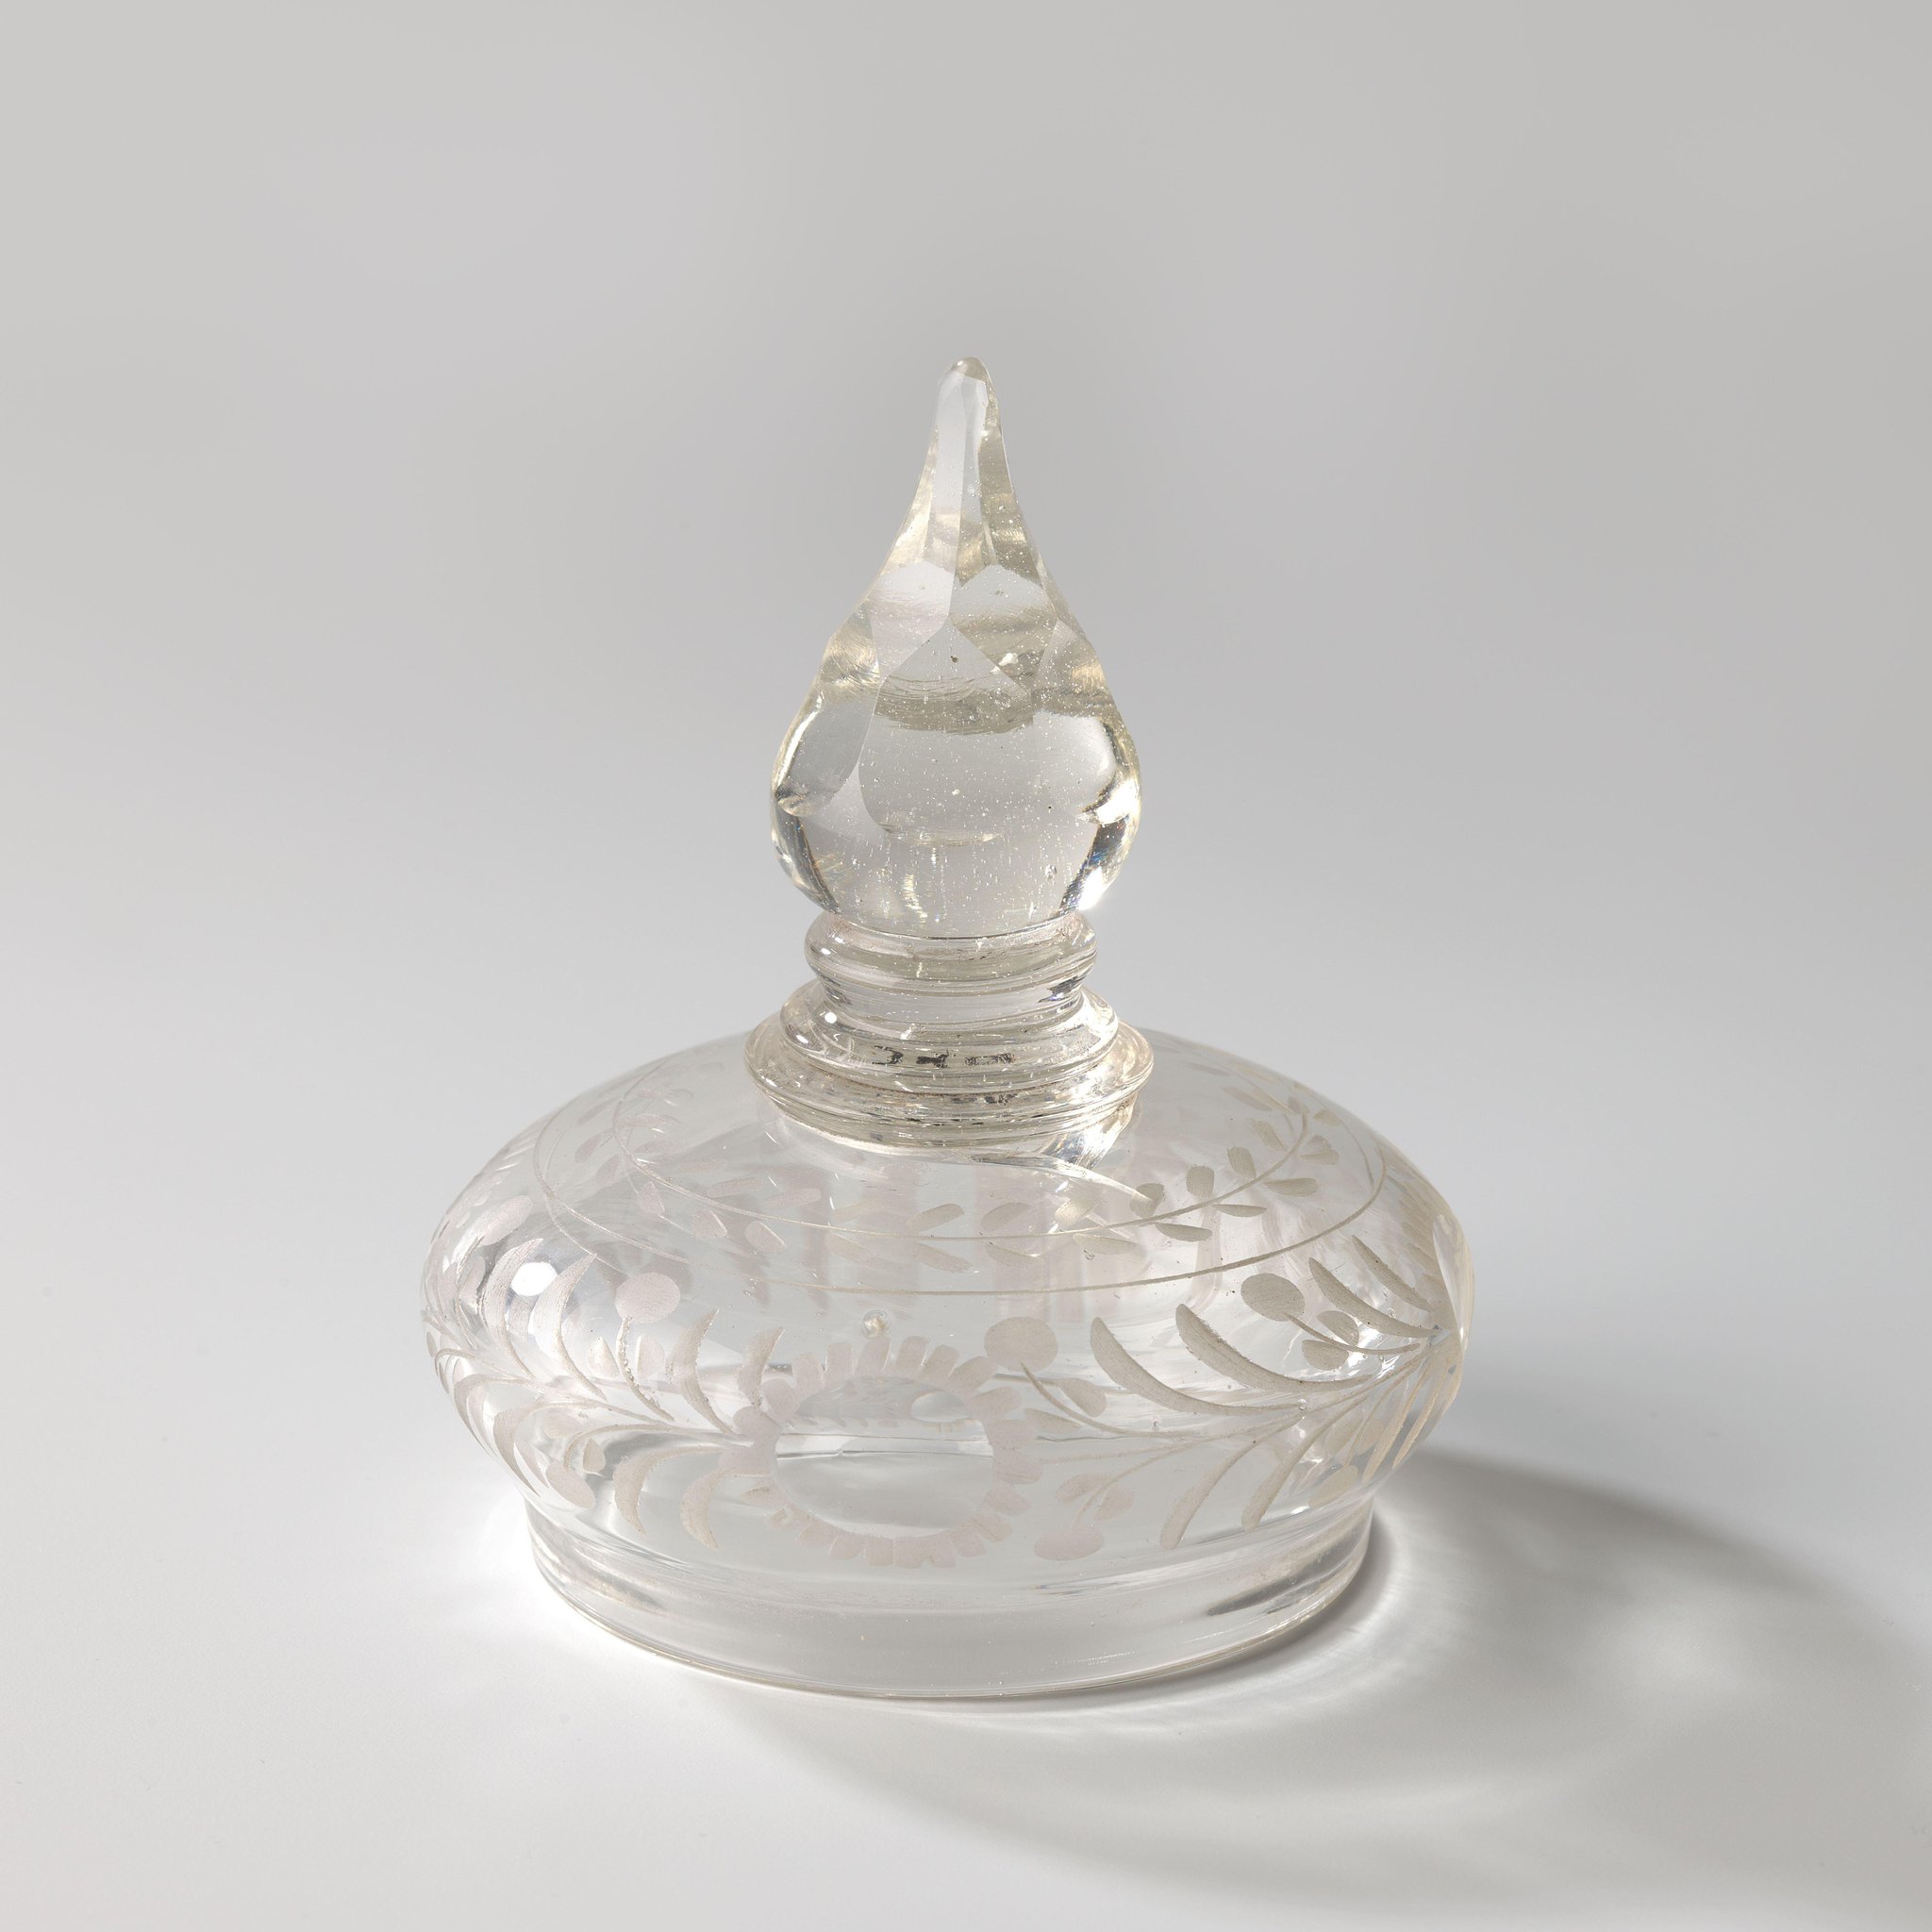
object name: lid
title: Deksel van een bokaal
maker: Anonymous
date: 1750-1800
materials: glass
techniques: glassblowing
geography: bohemia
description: Gefacetteerde, gewelfde deksel met gefacetteerde, peervormige knop op drie schijven. Op de deksel gegraveerde bladornamenten.